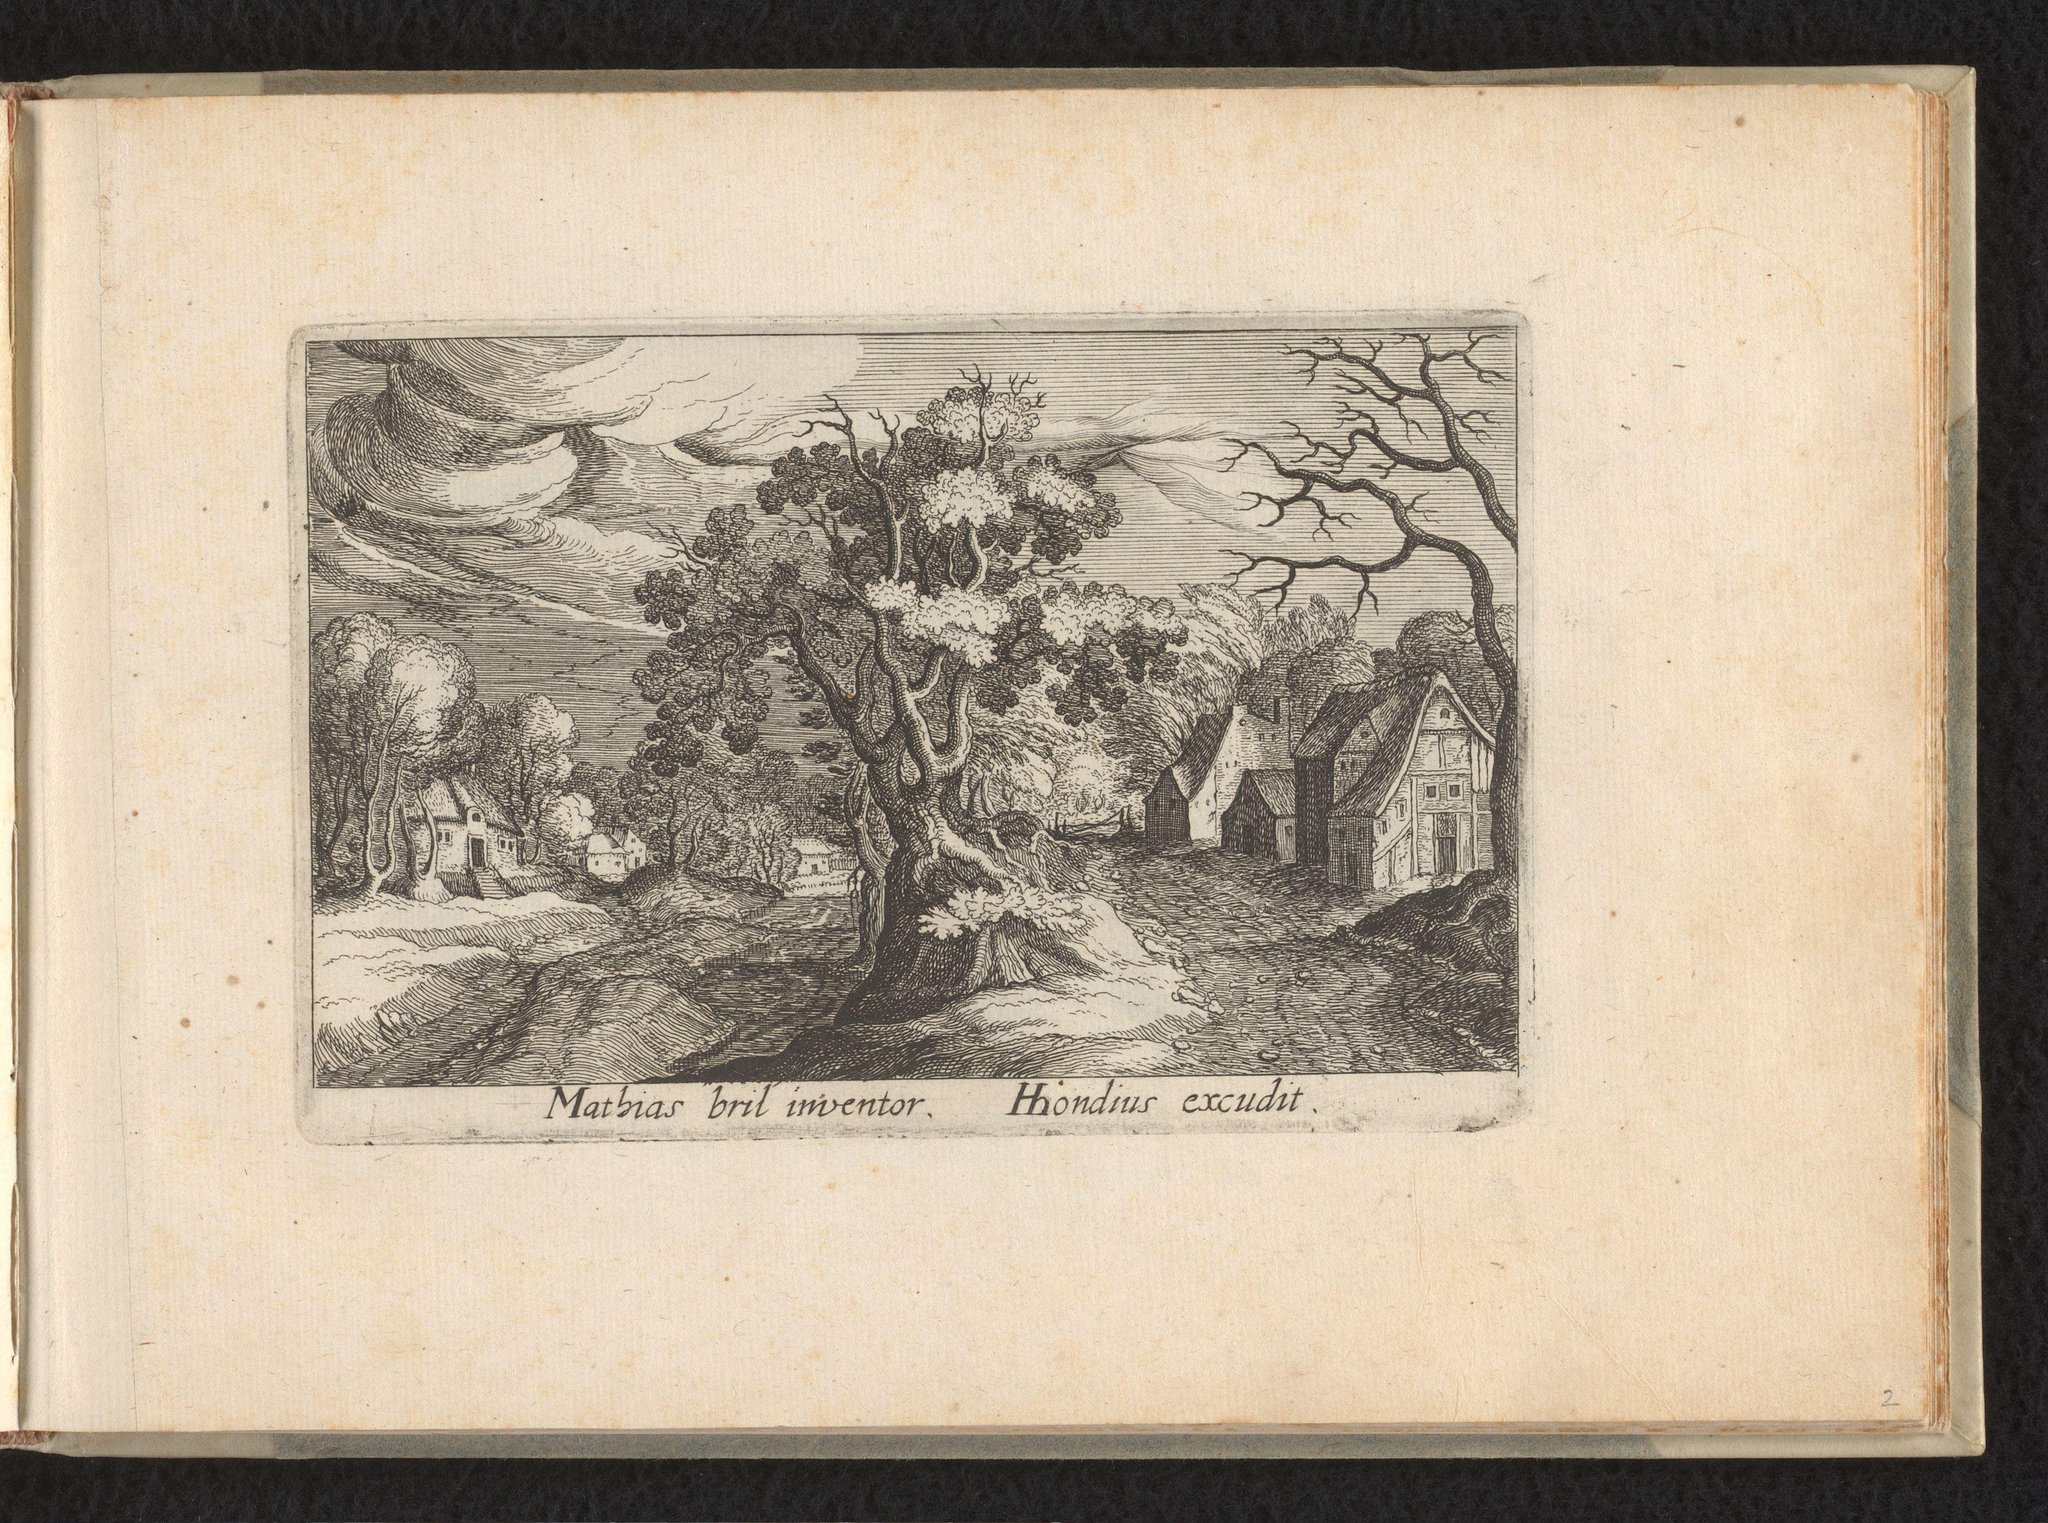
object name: print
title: Topographia Variarum Regionum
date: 1614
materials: paper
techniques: etching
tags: landscapes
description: Landschap met boom in het midden, links en rechts ervan een zandpad met kleine huizen. Stormachtige lucht.